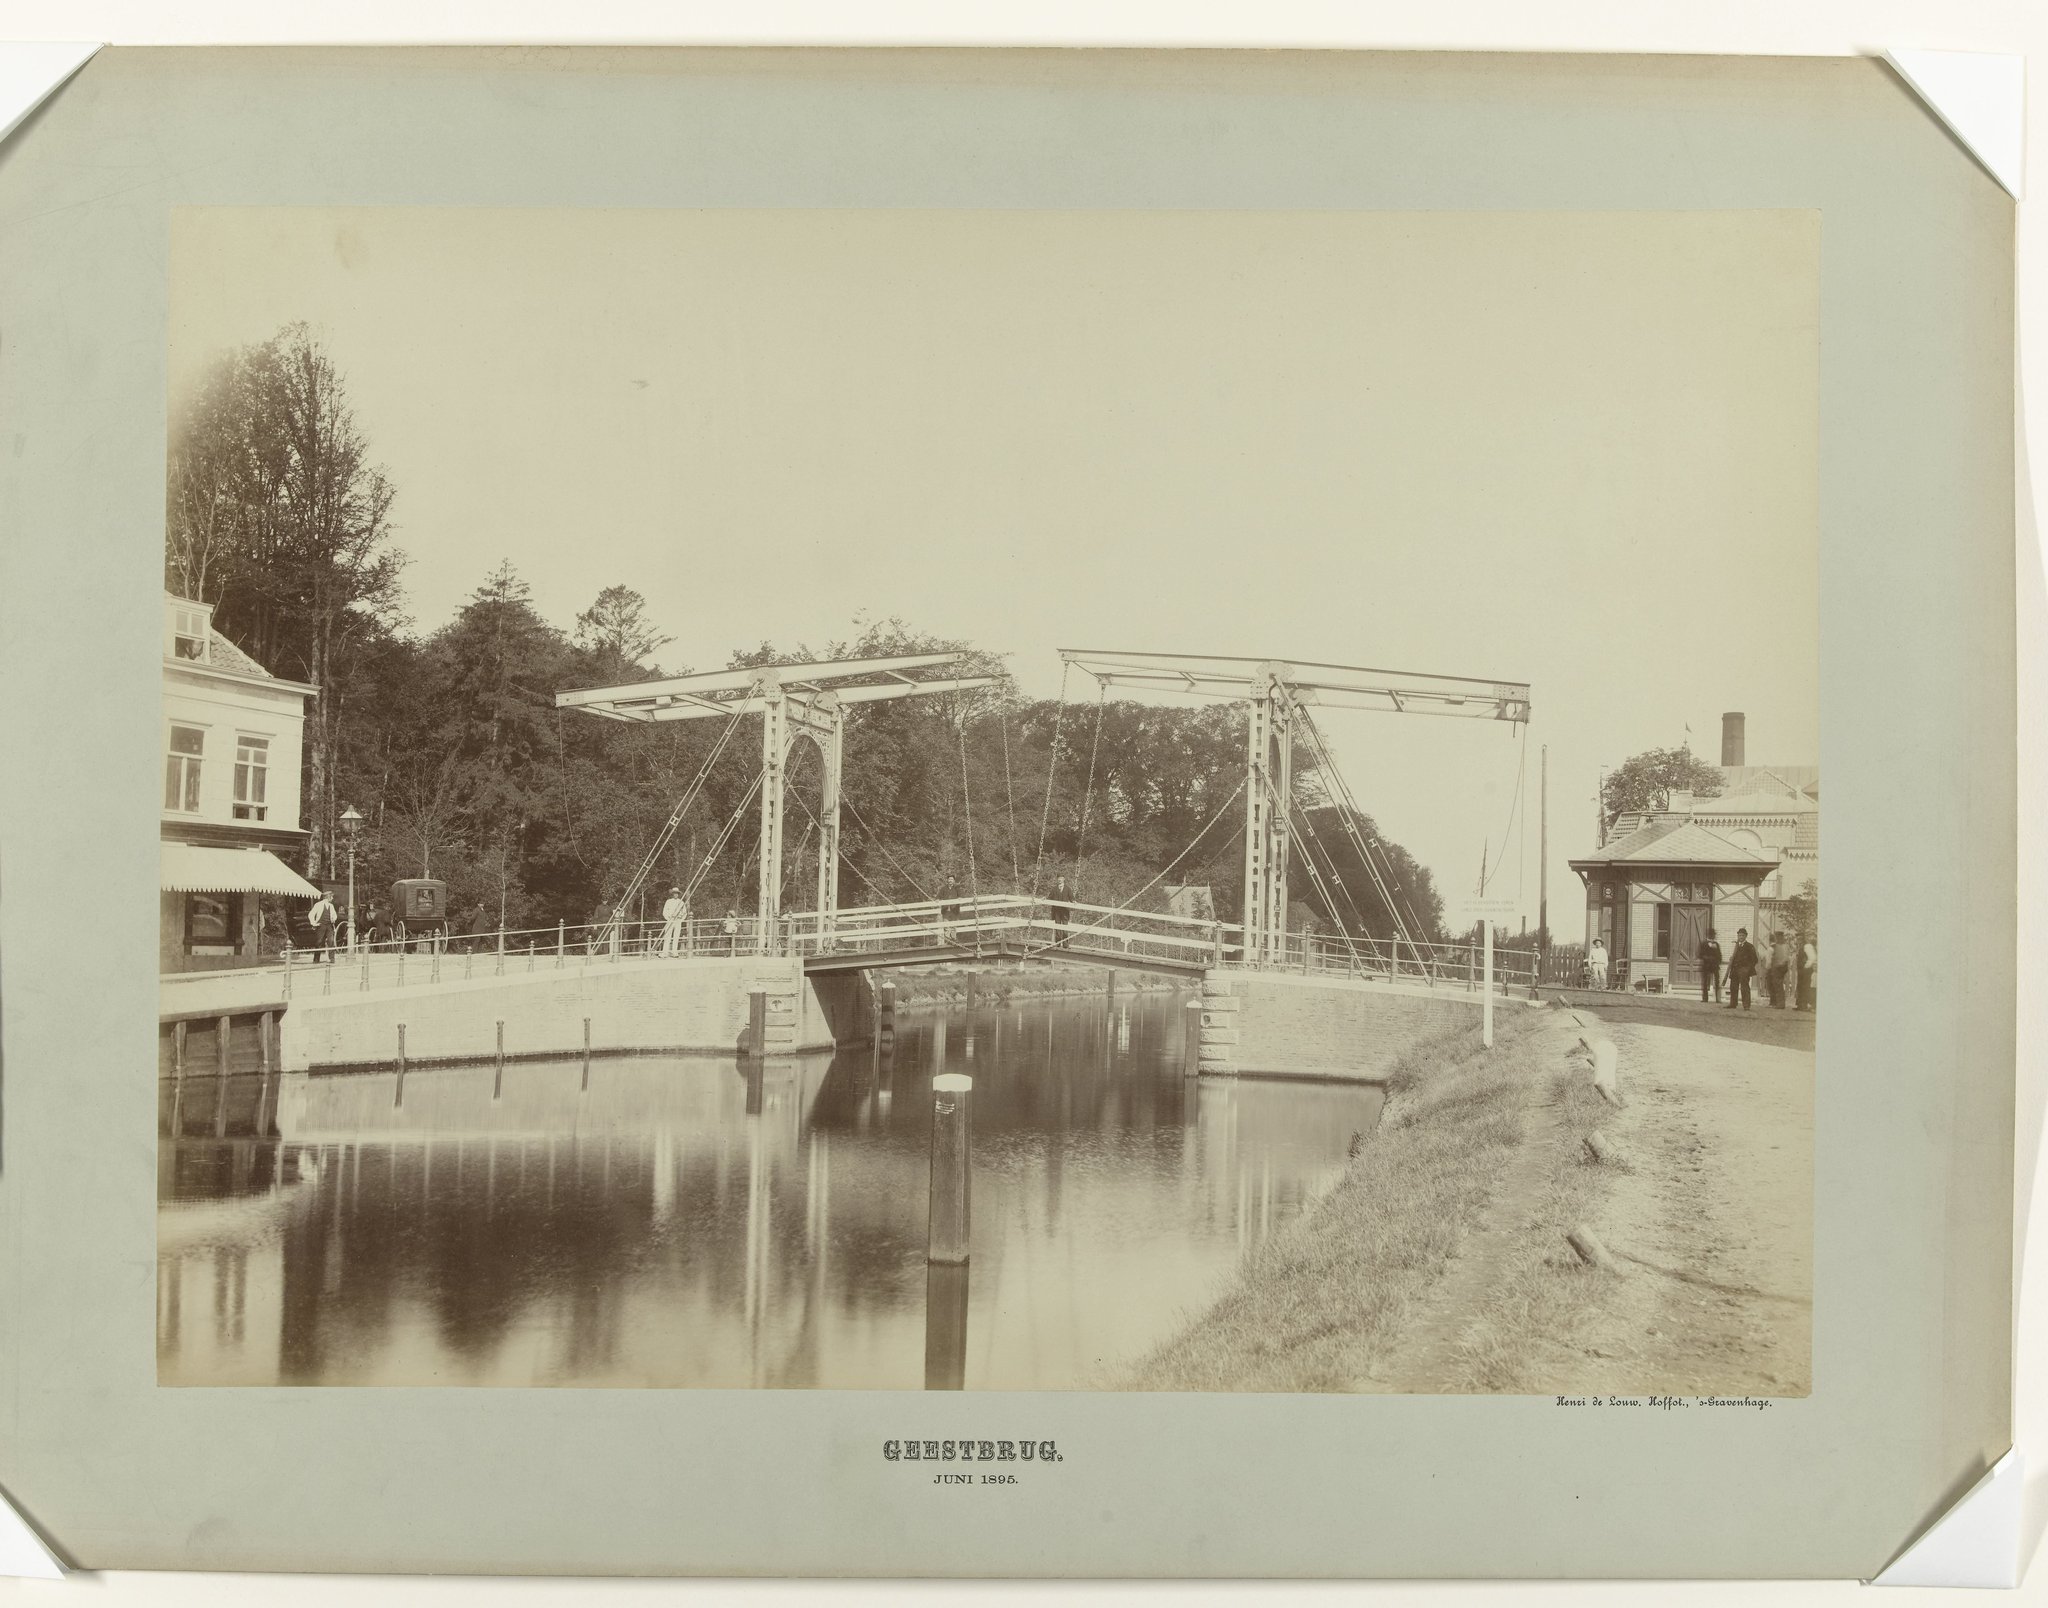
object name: photograph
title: Geestbrug te Voorburg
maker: henri de louw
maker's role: fotograaf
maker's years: 1851-1944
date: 1806-1895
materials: cardboard, photographic support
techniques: albumen print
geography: the hague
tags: bridge in city across river, canal, etc.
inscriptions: date